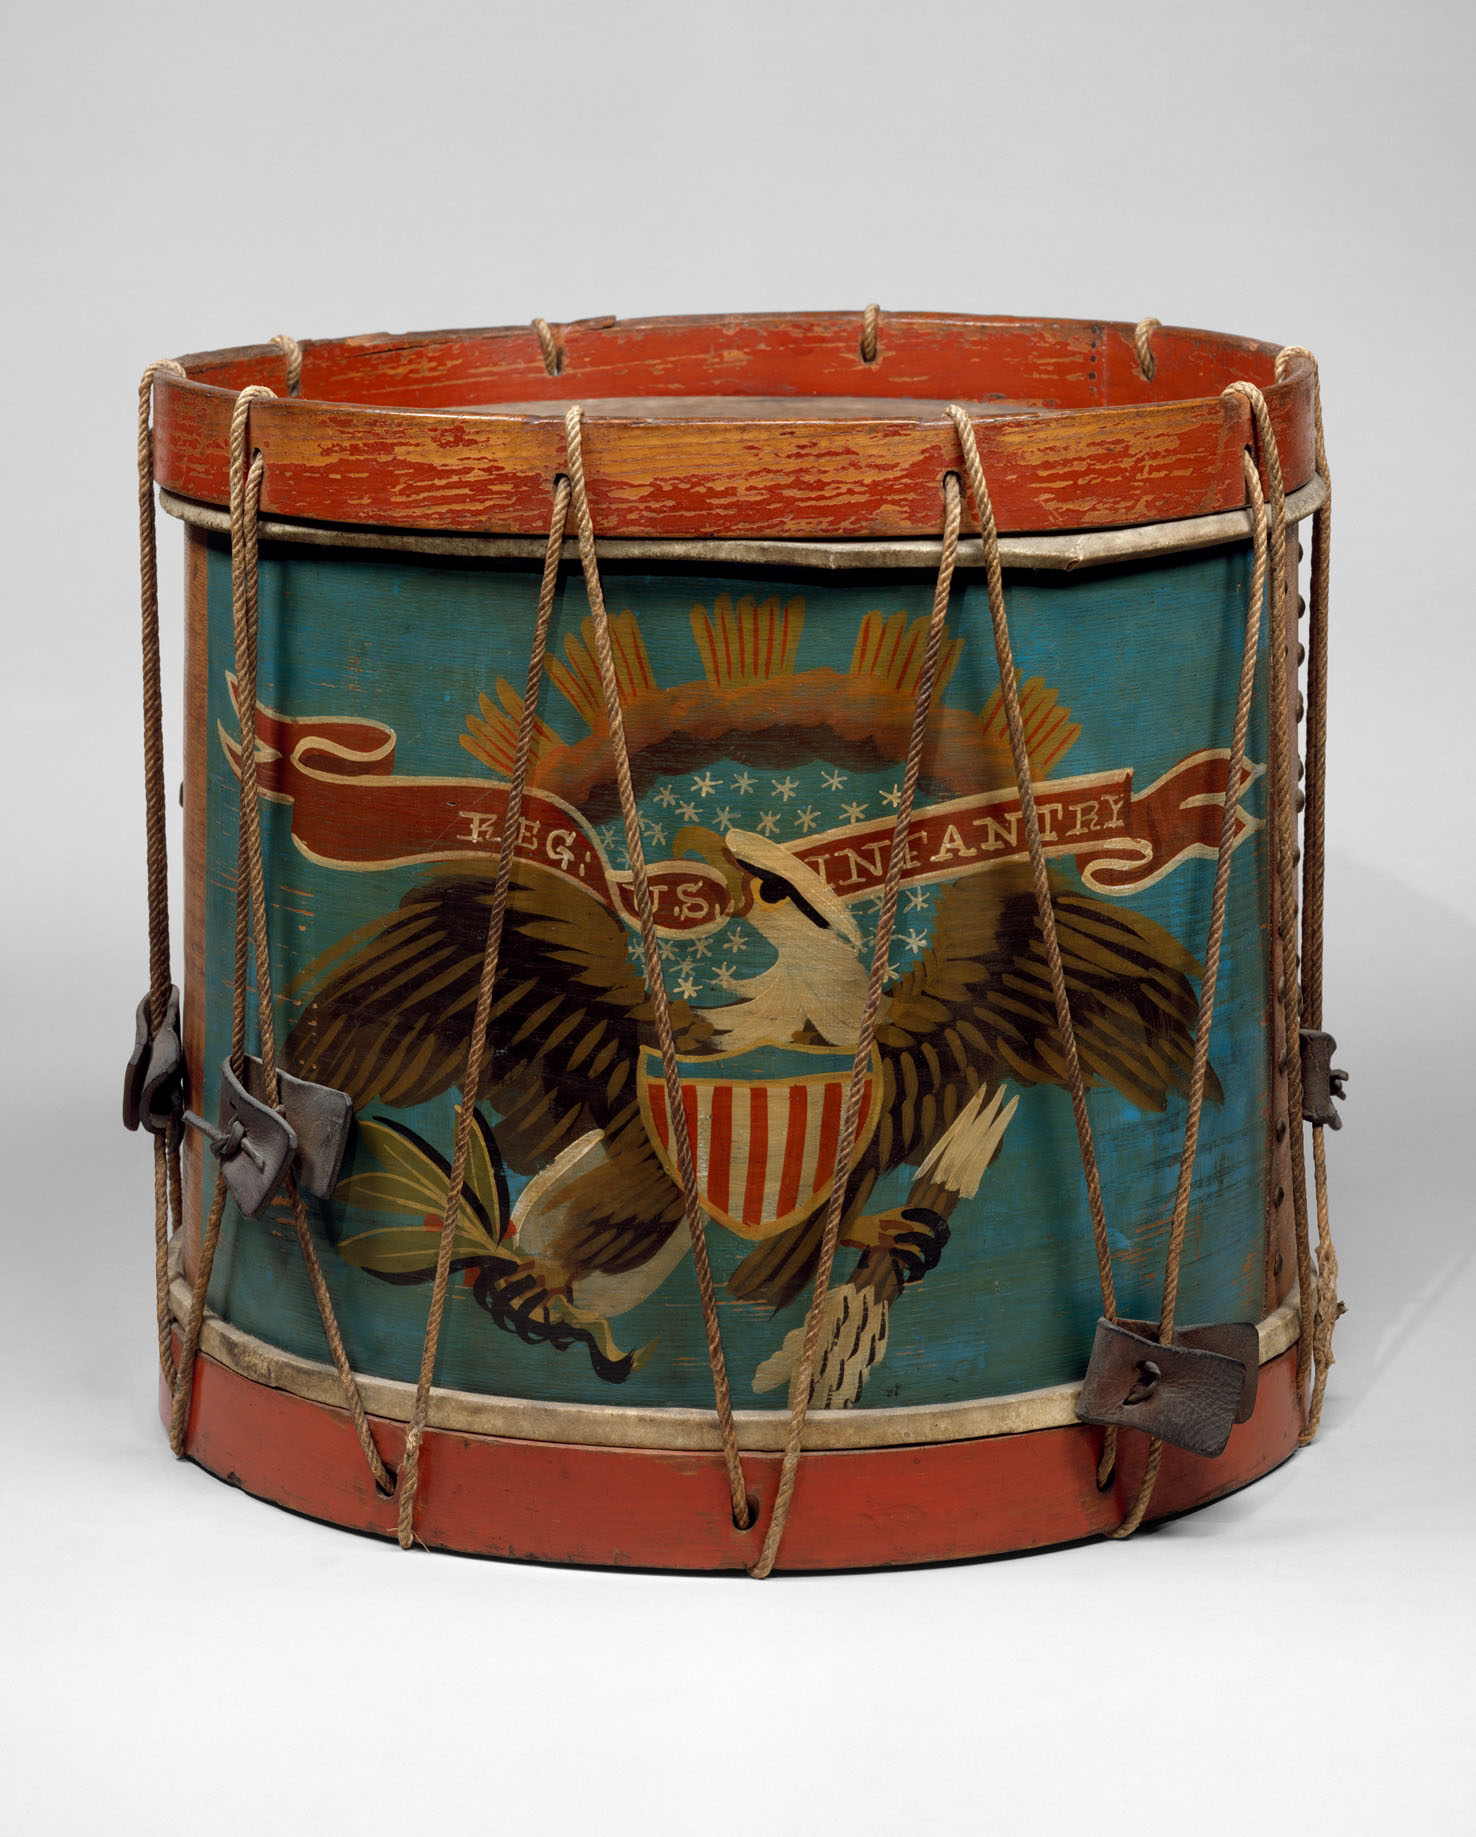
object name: side drum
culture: american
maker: ernest vogt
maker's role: maker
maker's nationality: american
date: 1864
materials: leather, fiber, skin, wood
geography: united states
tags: eagles